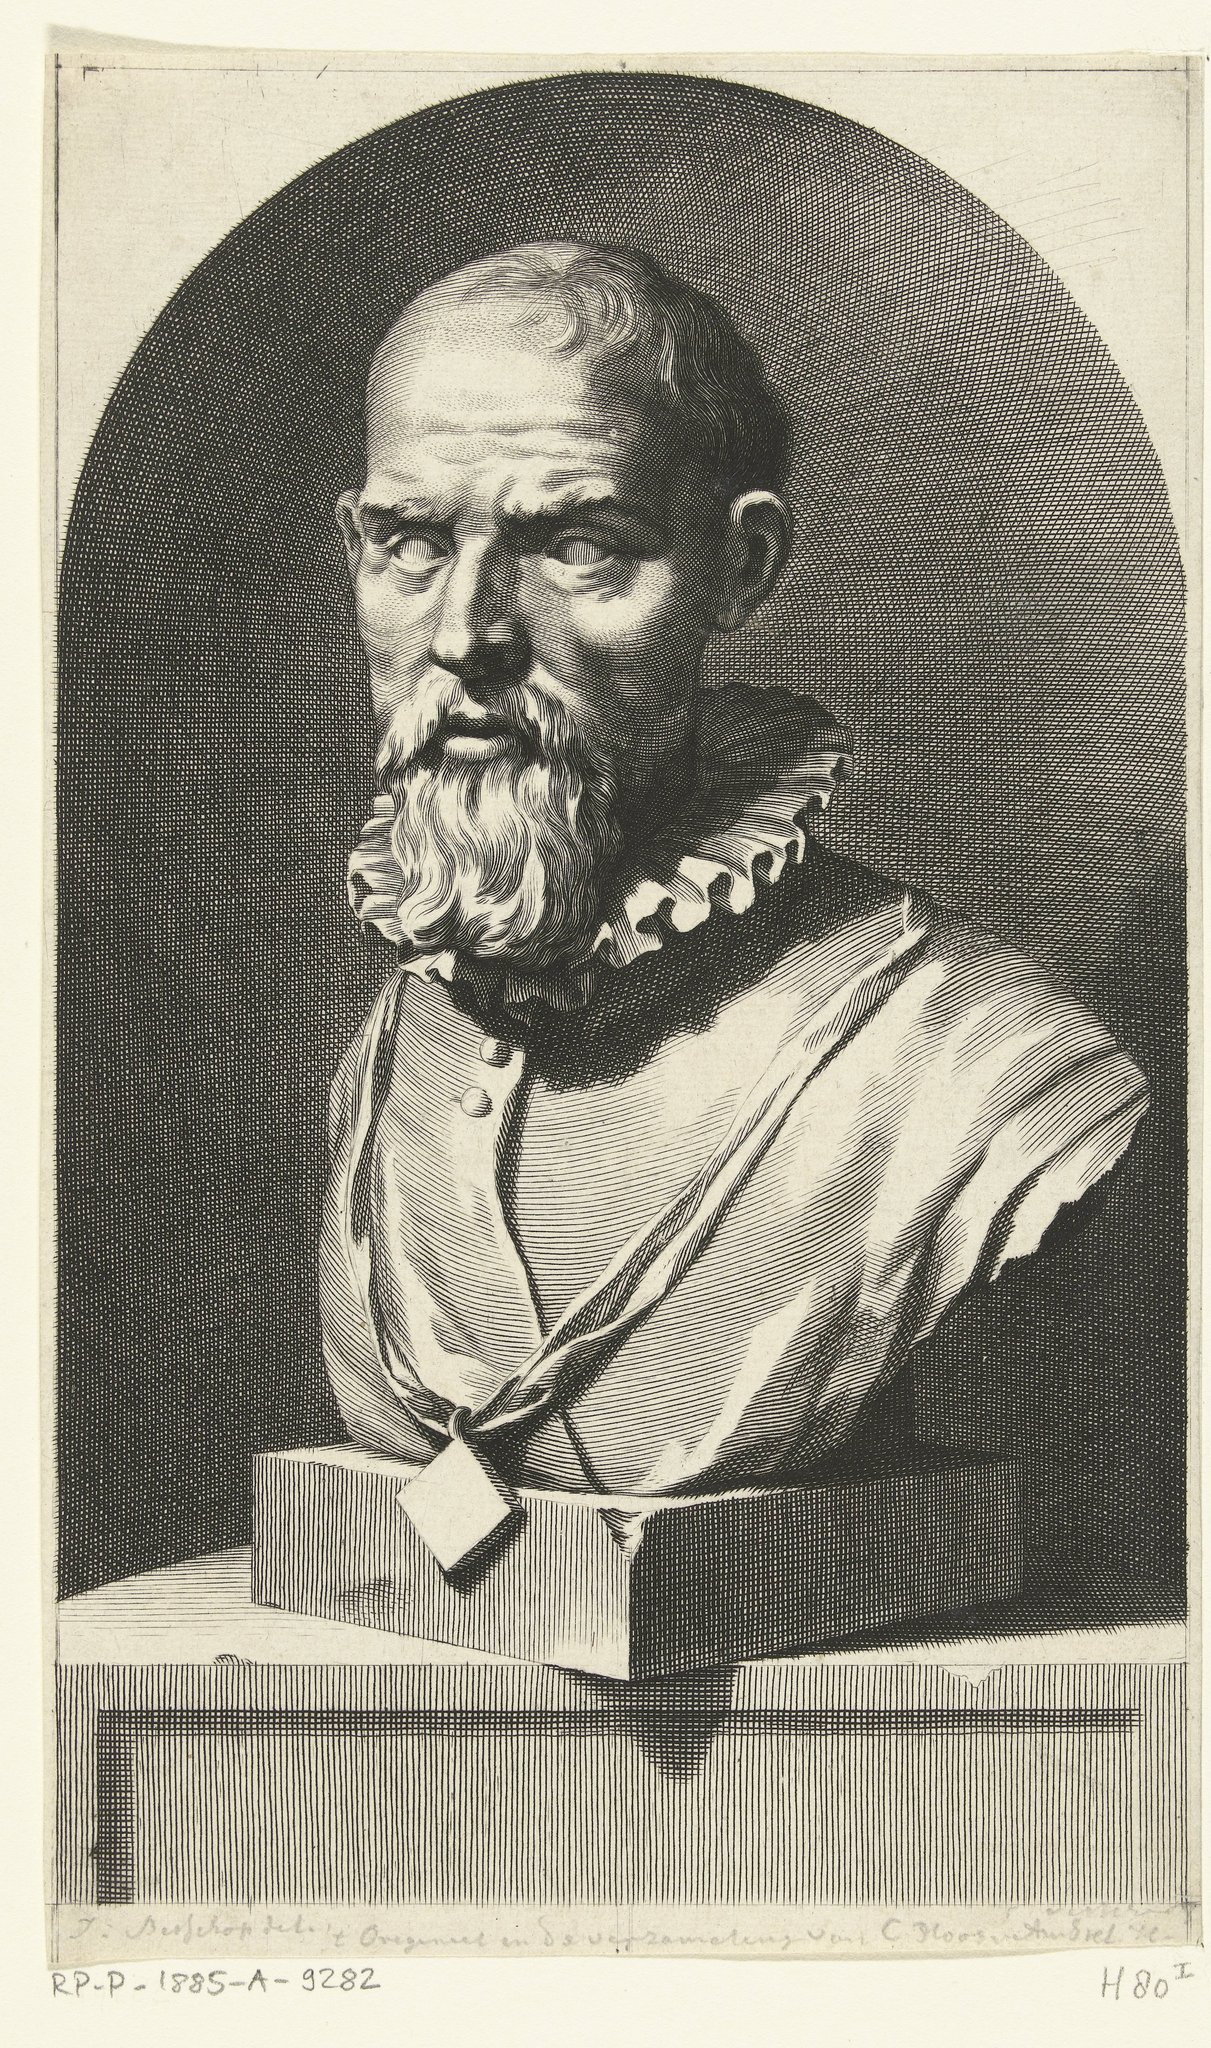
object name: print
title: Portretbuste van Pieter Adriaansz. van der Werff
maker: hendrik bary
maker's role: draughtsman, print maker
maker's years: 1640-1707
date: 1657-1707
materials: paper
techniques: engraving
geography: netherlands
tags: mayor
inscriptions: collector's mark: Lugt 2228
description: Afbeelding van een stenen portretbuste van Pieter Adriaansz. van der Werff.